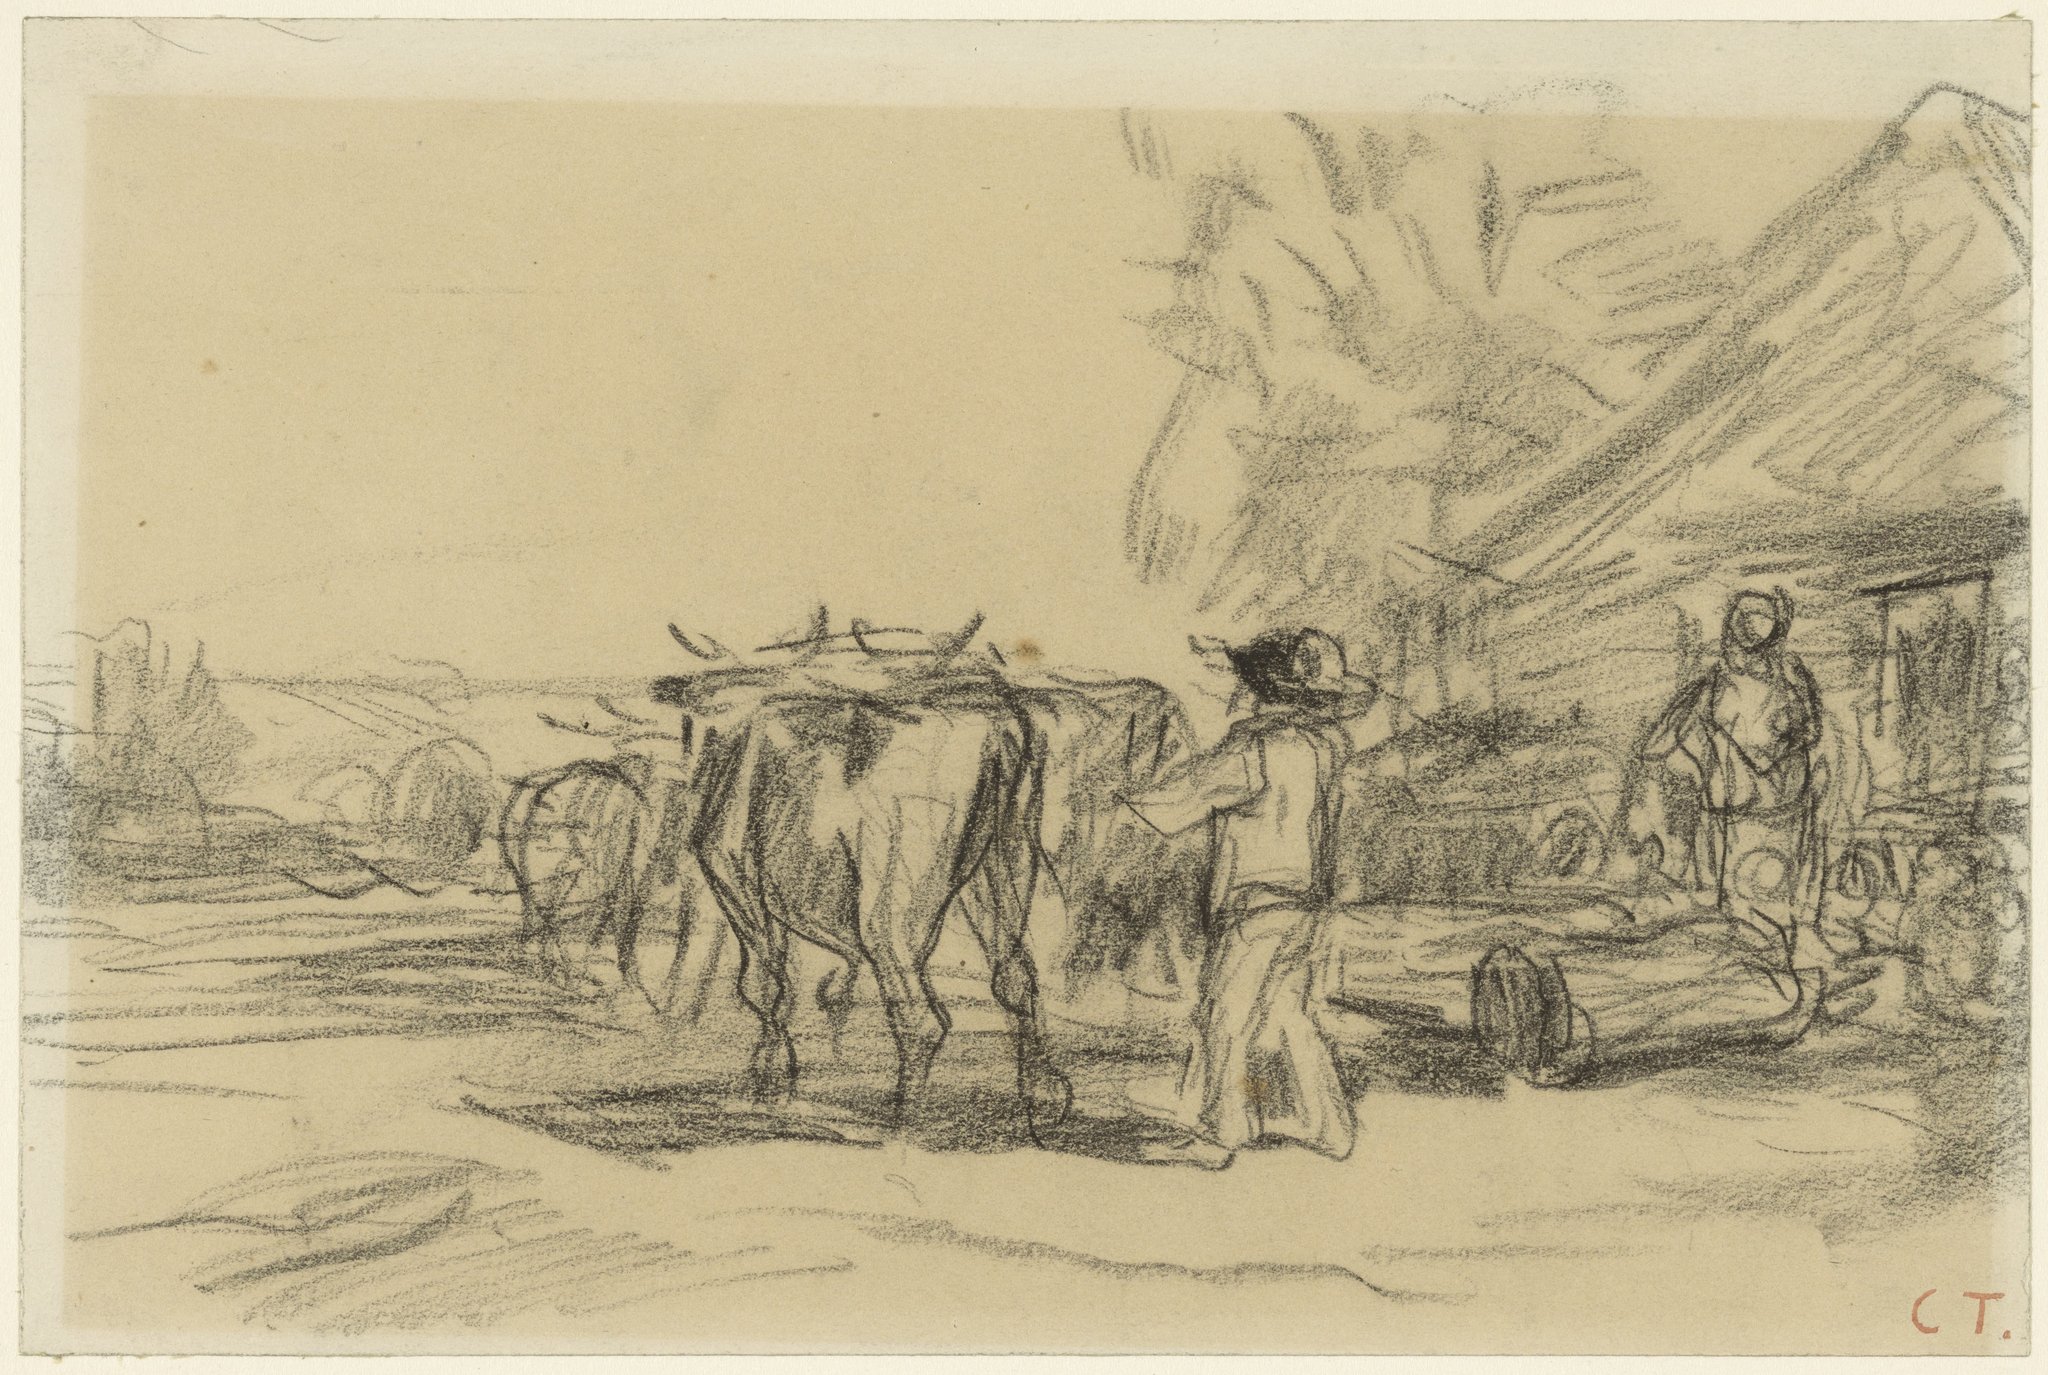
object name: drawing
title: Man met een span ossen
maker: constant troyon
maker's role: draughtsman, painter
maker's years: 1810-1865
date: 1820-1865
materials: chalk, paper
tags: ox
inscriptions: signature: ‘CT.’